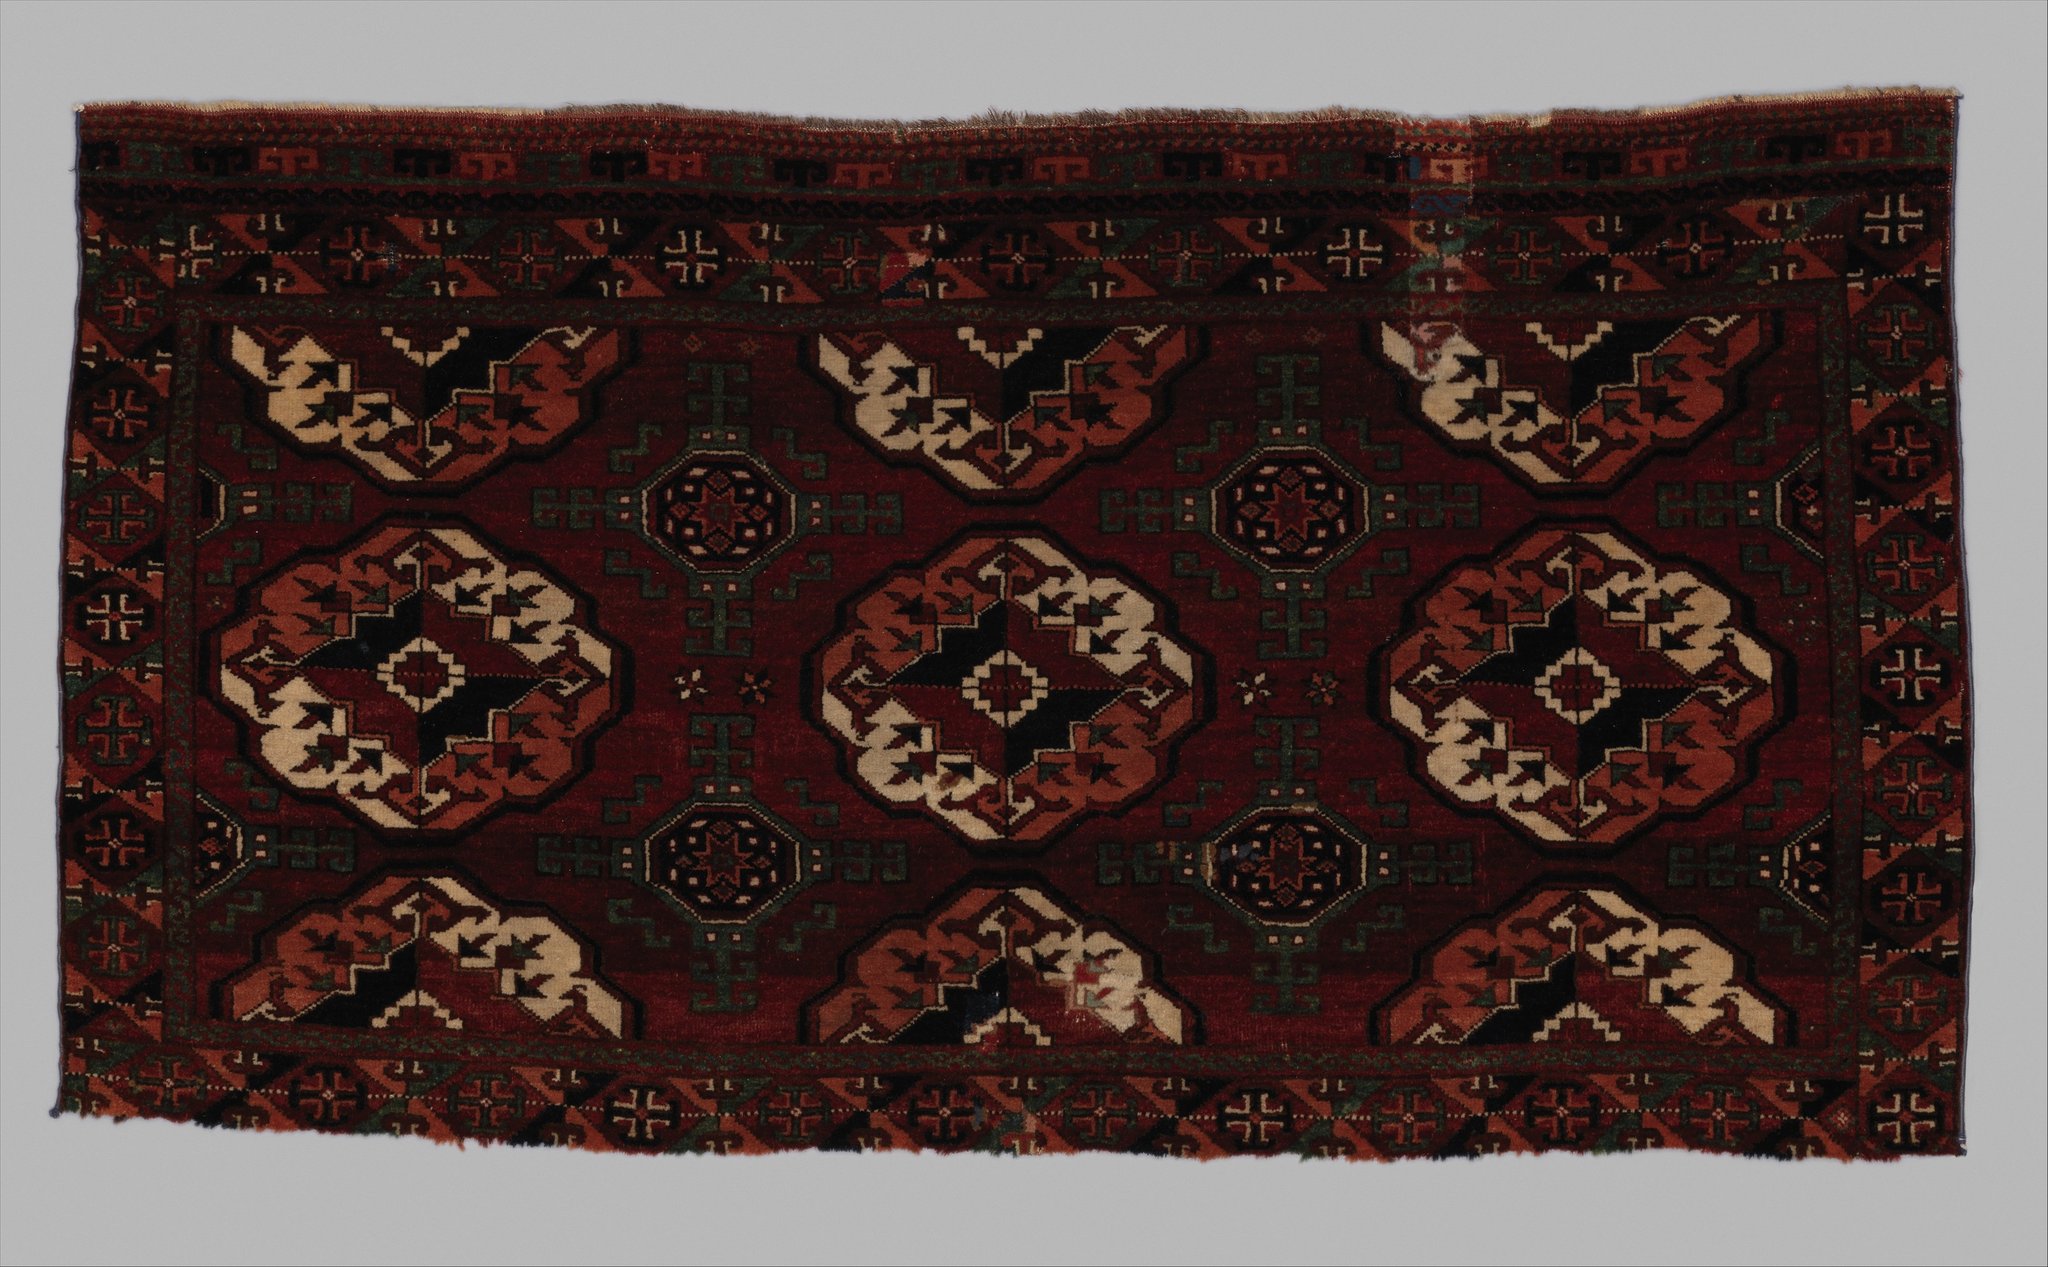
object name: storage bag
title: Storage Bag (Chuval) Face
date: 1801-1833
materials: cotton, wool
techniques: asymmetrically knotted pile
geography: central asia